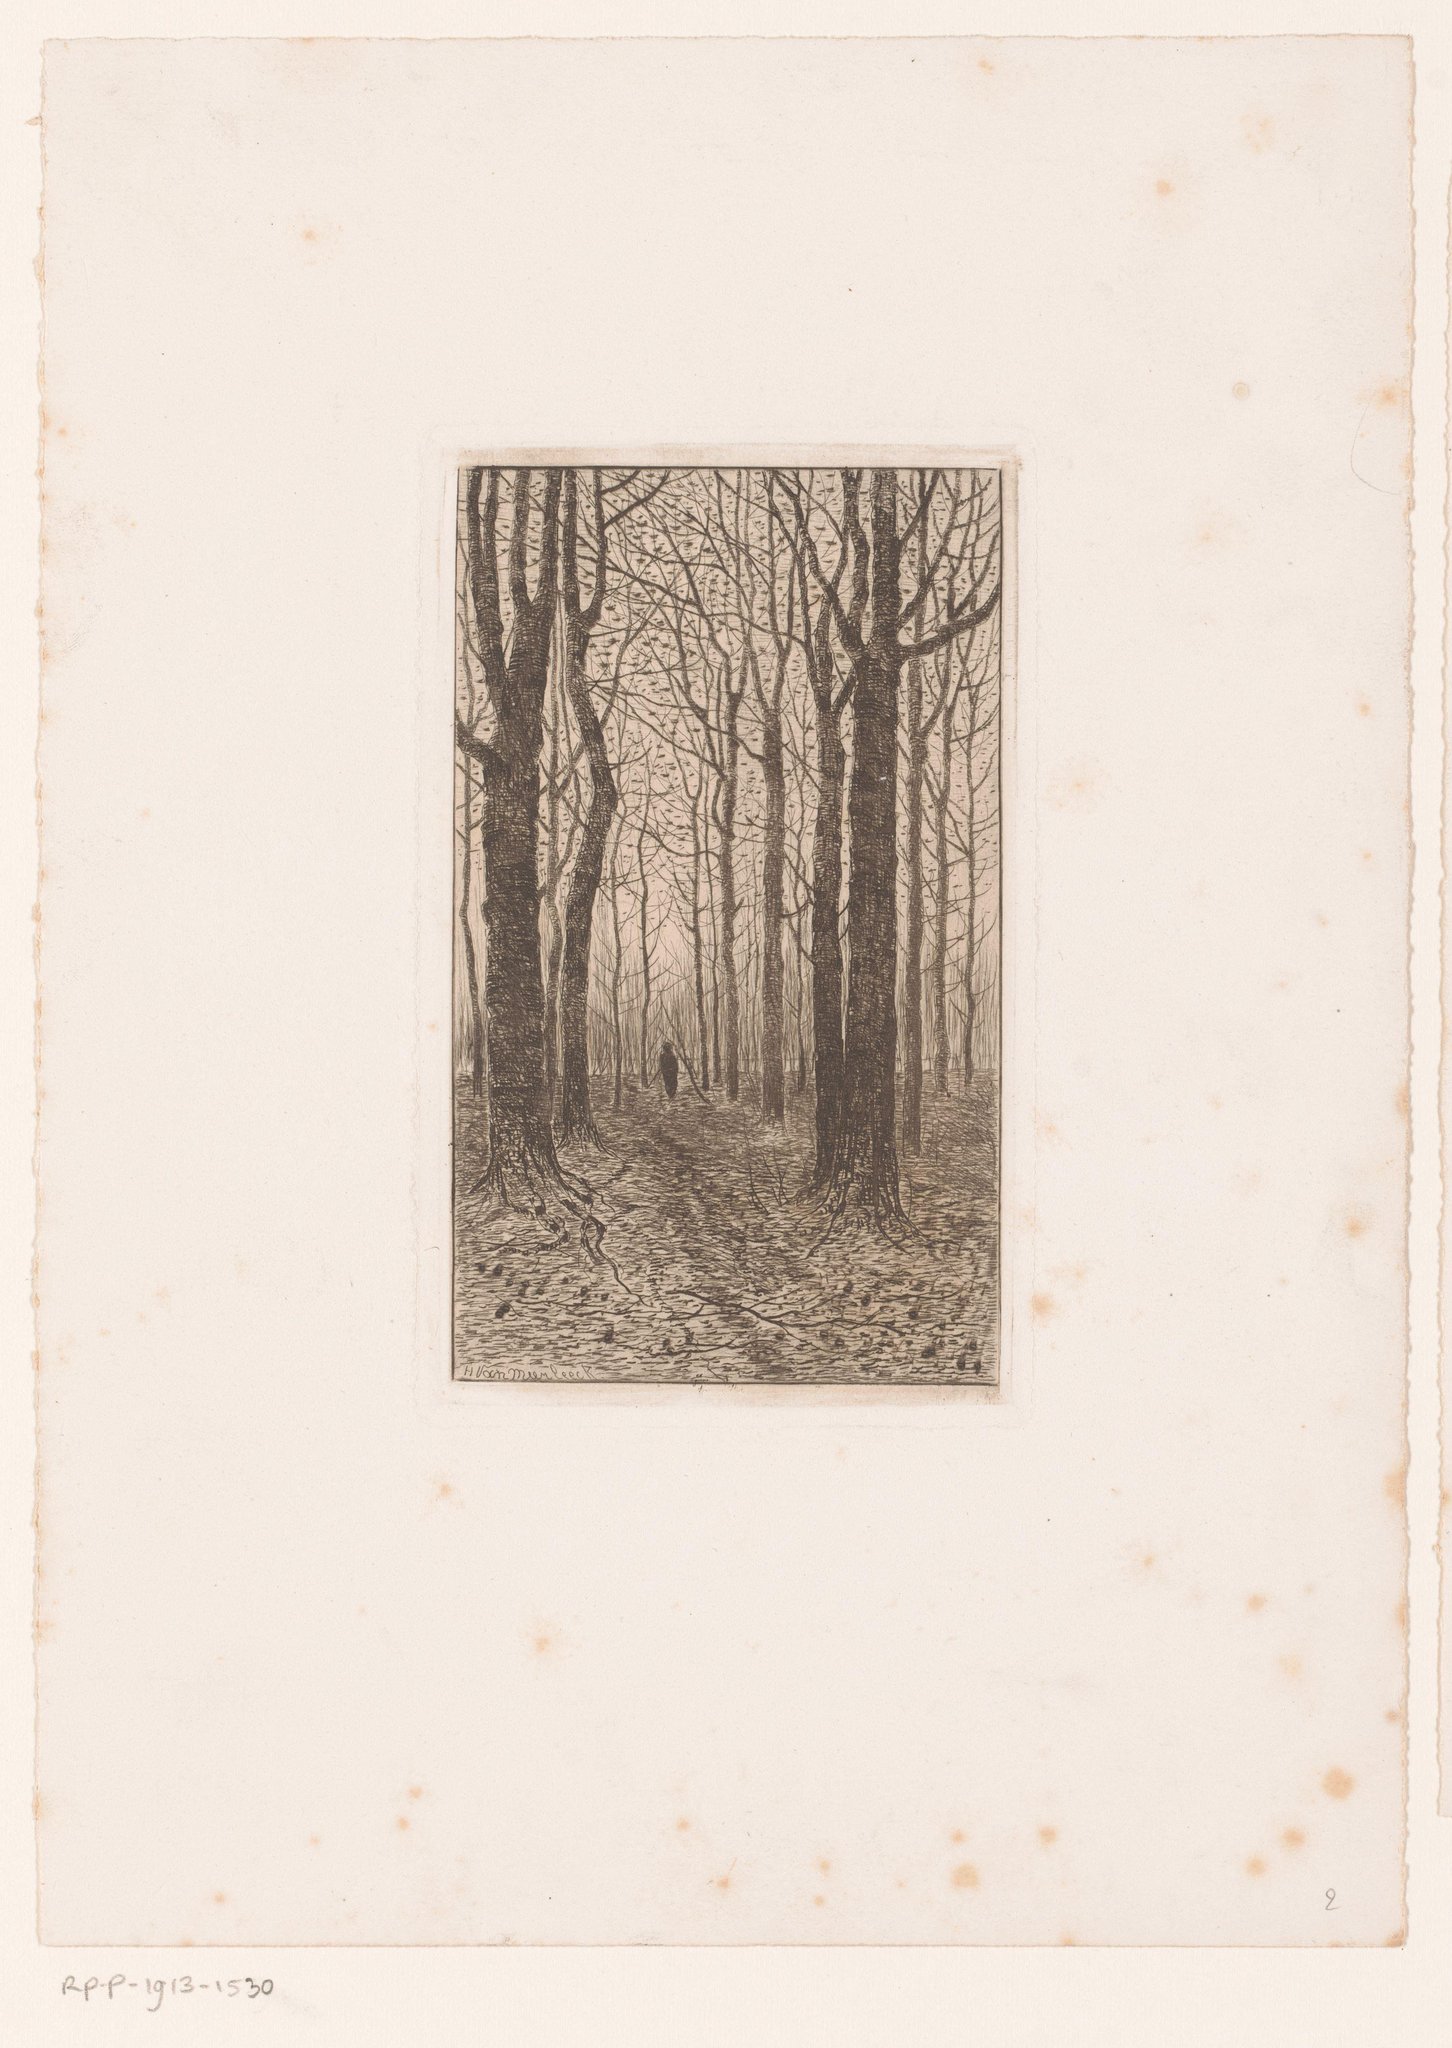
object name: print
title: Figuur in een bos met hoge bomen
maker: h. van meerbeeck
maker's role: print maker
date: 1850-1913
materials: paper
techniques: etching, intaglio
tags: forest, wood (+ landscape with figures, staffage)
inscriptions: collector's mark: Lugt 2228